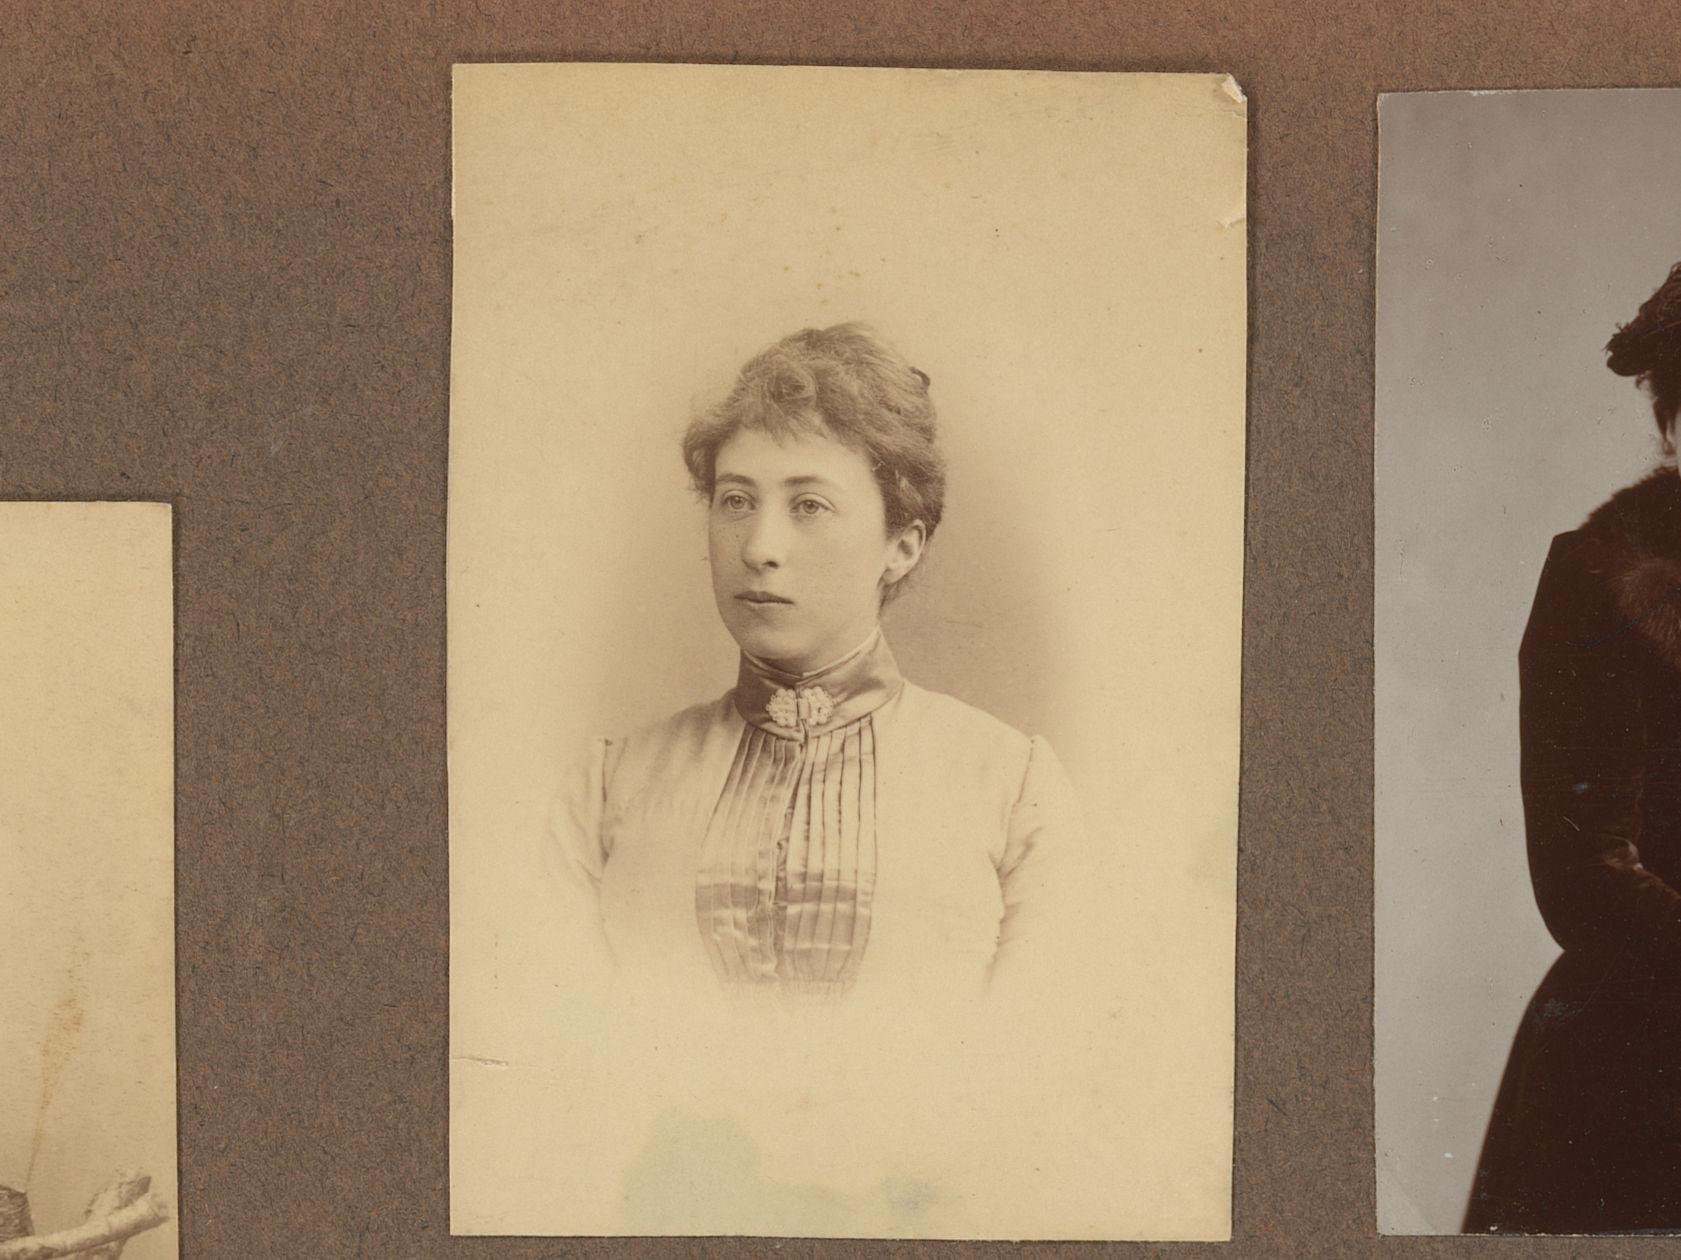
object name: photograph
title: Portret van vrouw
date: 1870-1920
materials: photographic support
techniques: photography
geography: netherlands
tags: netherlands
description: Foto op bruin albumblad 34 van familiealbum van Alphons Diepenbrock.